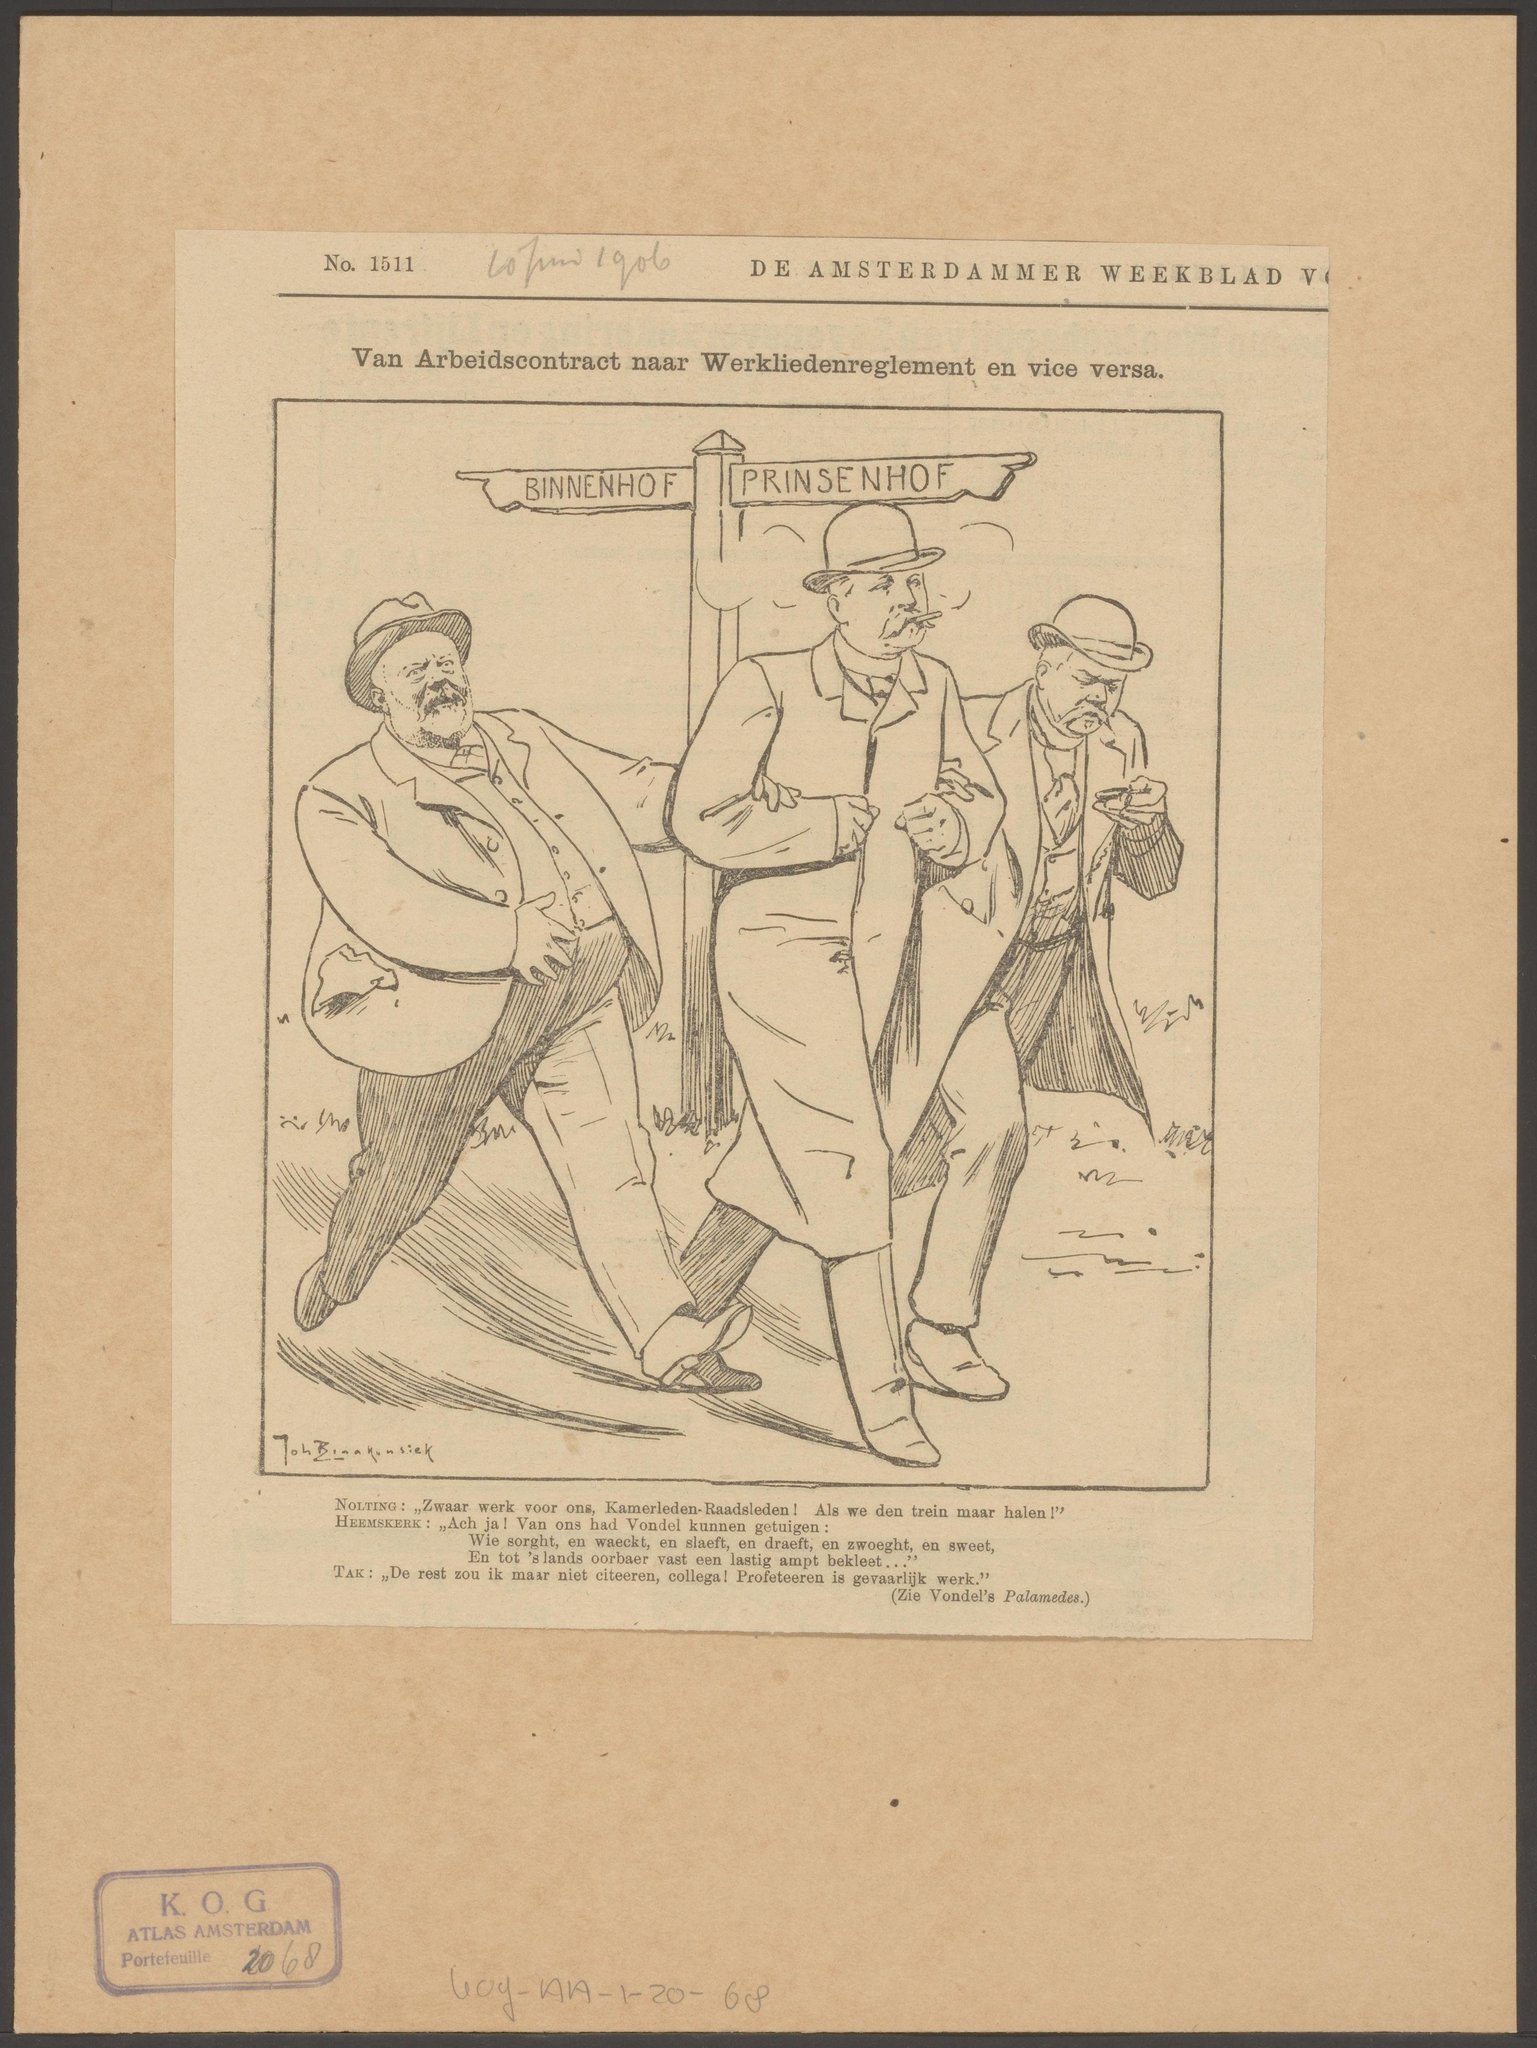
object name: cartoon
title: Van Arbeiderscontract naar Werkliedenreglement en vice versa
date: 1906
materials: paper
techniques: letterpress printing, line block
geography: netherlands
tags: politician, amsterdam, utrecht, middelburg, pieter lodewijk tak, signpost, politician, e.g. party leader, political caricatures and satires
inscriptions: collector's mark: Lugt 1641b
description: Onderwerpsrubriek binnen de Atlas Amsterdam: Verkiezingen Tweede Kamer.